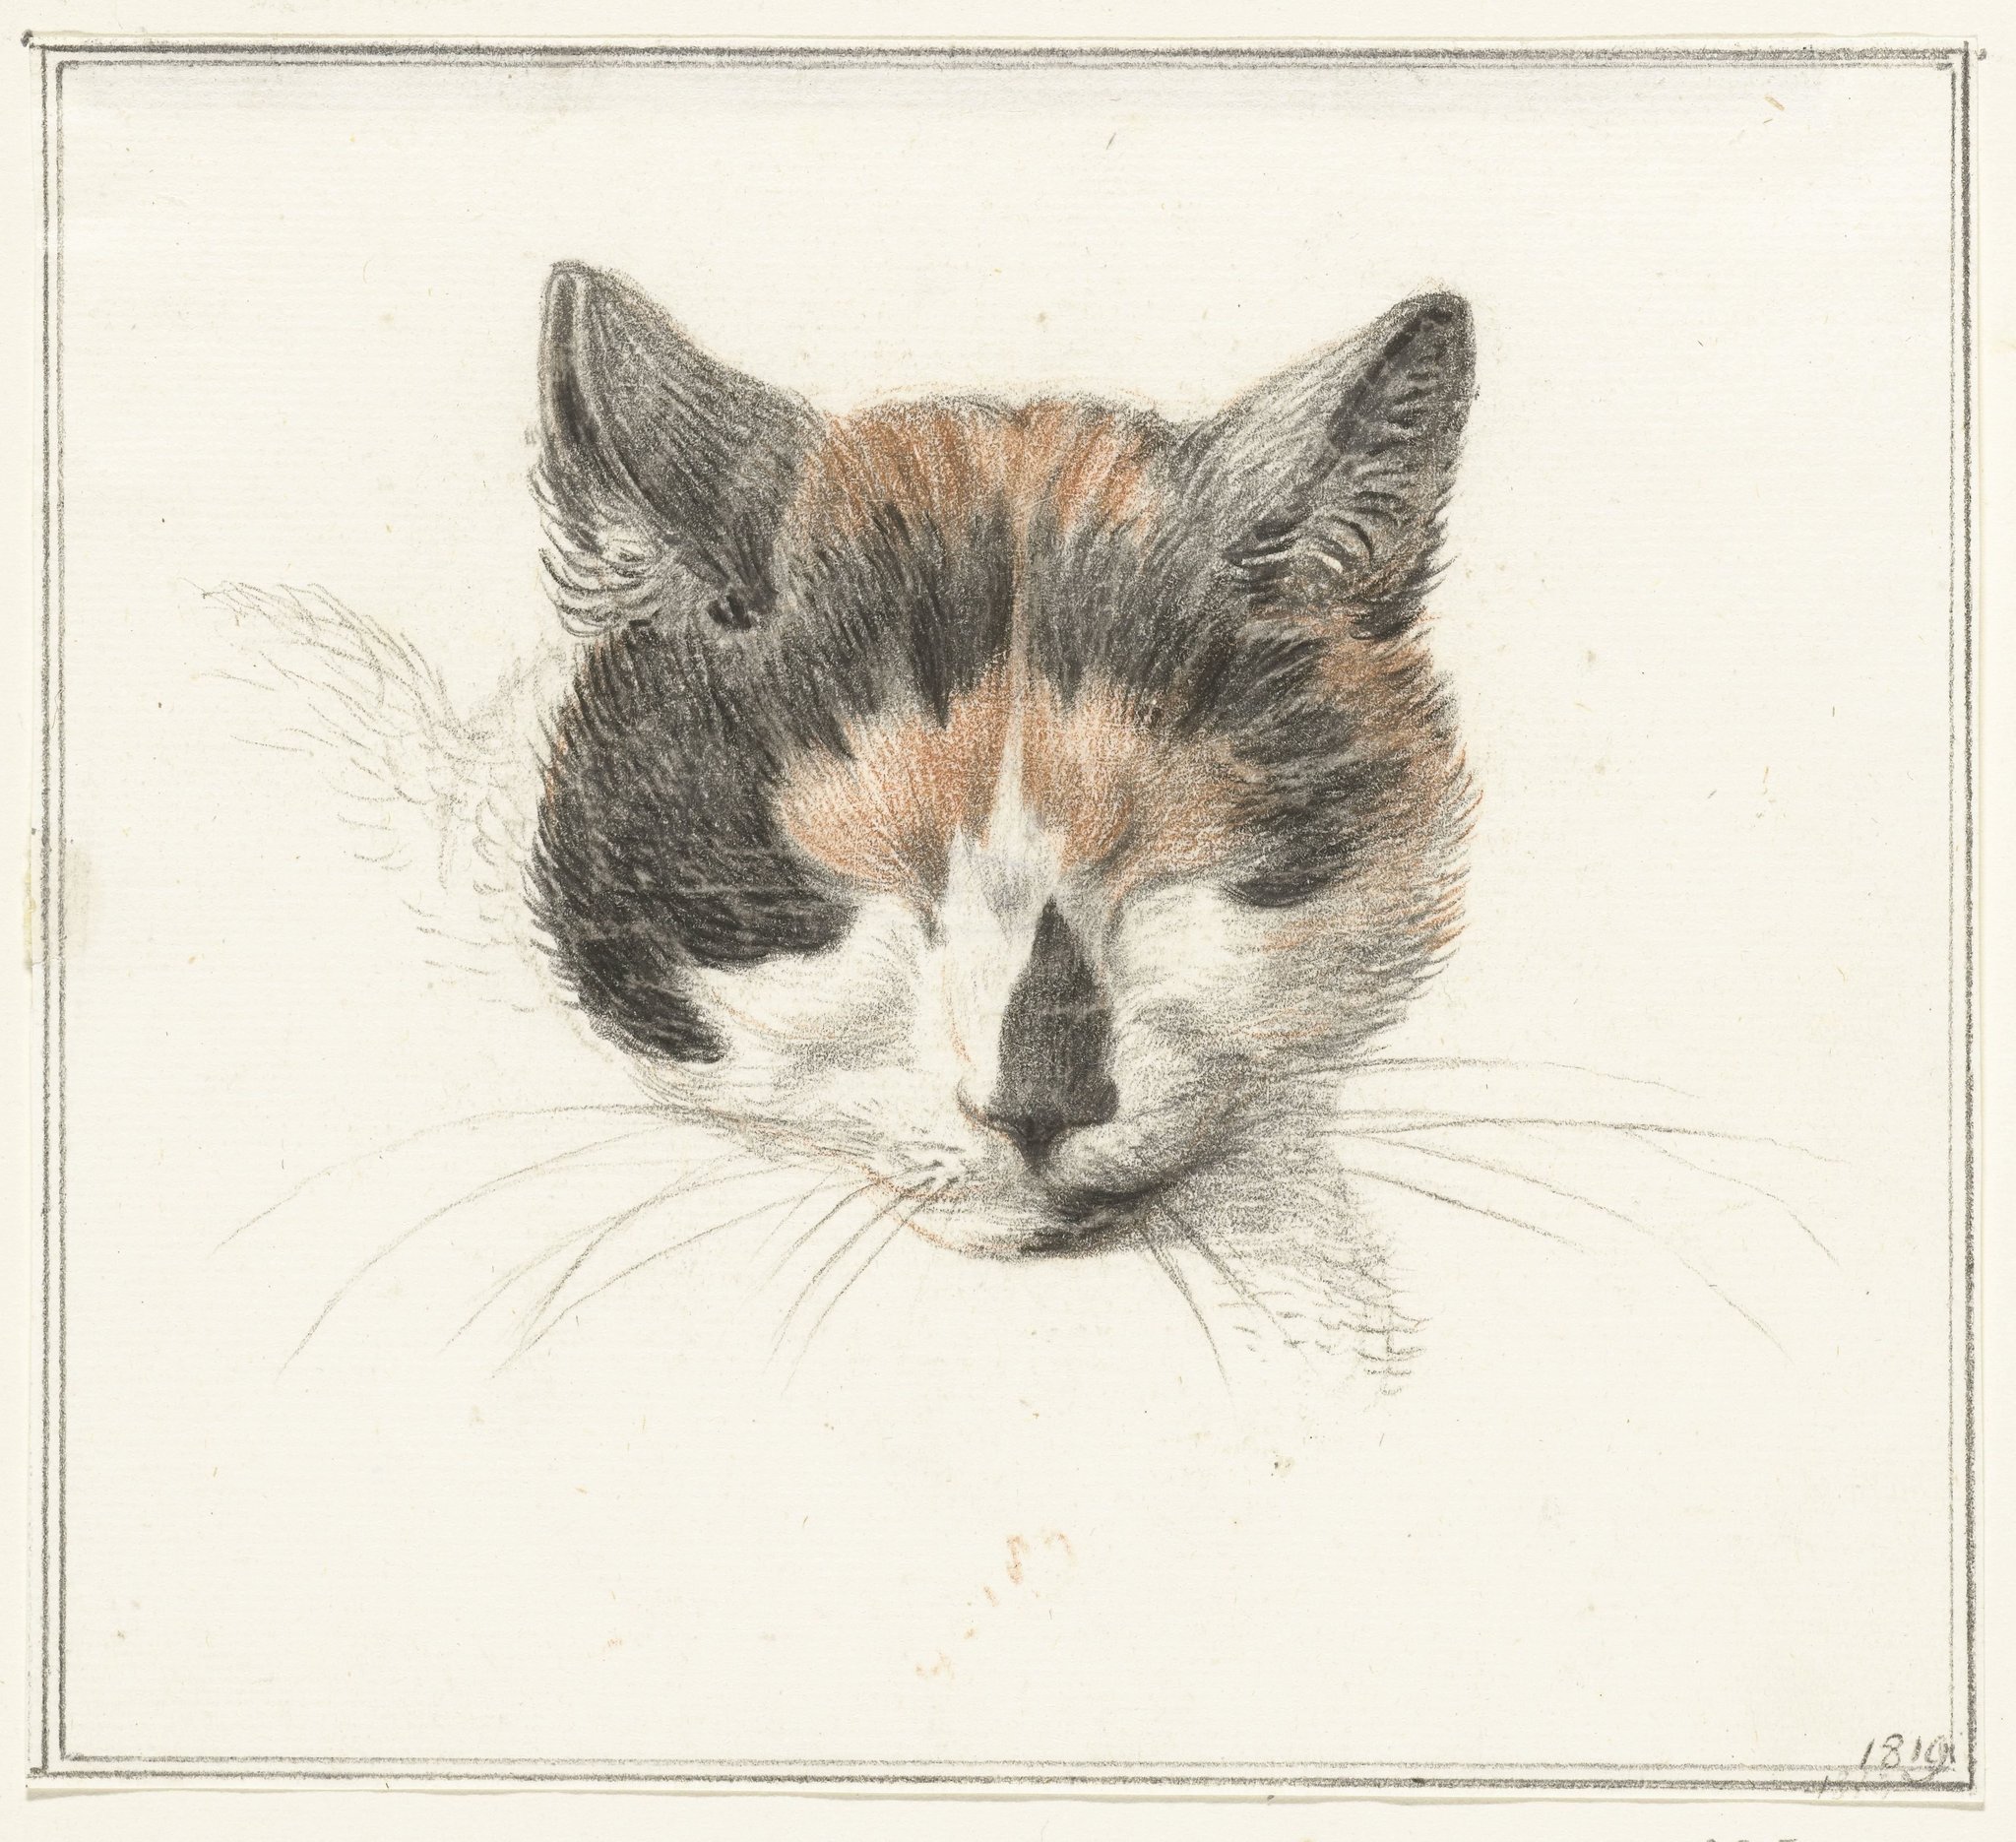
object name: drawing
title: Kop van een lapjeskat, van voren, met gesloten ogen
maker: jean bernard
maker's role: draughtsman, print maker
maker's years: 1765-1833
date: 1819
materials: chalk, paper, pencil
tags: cat